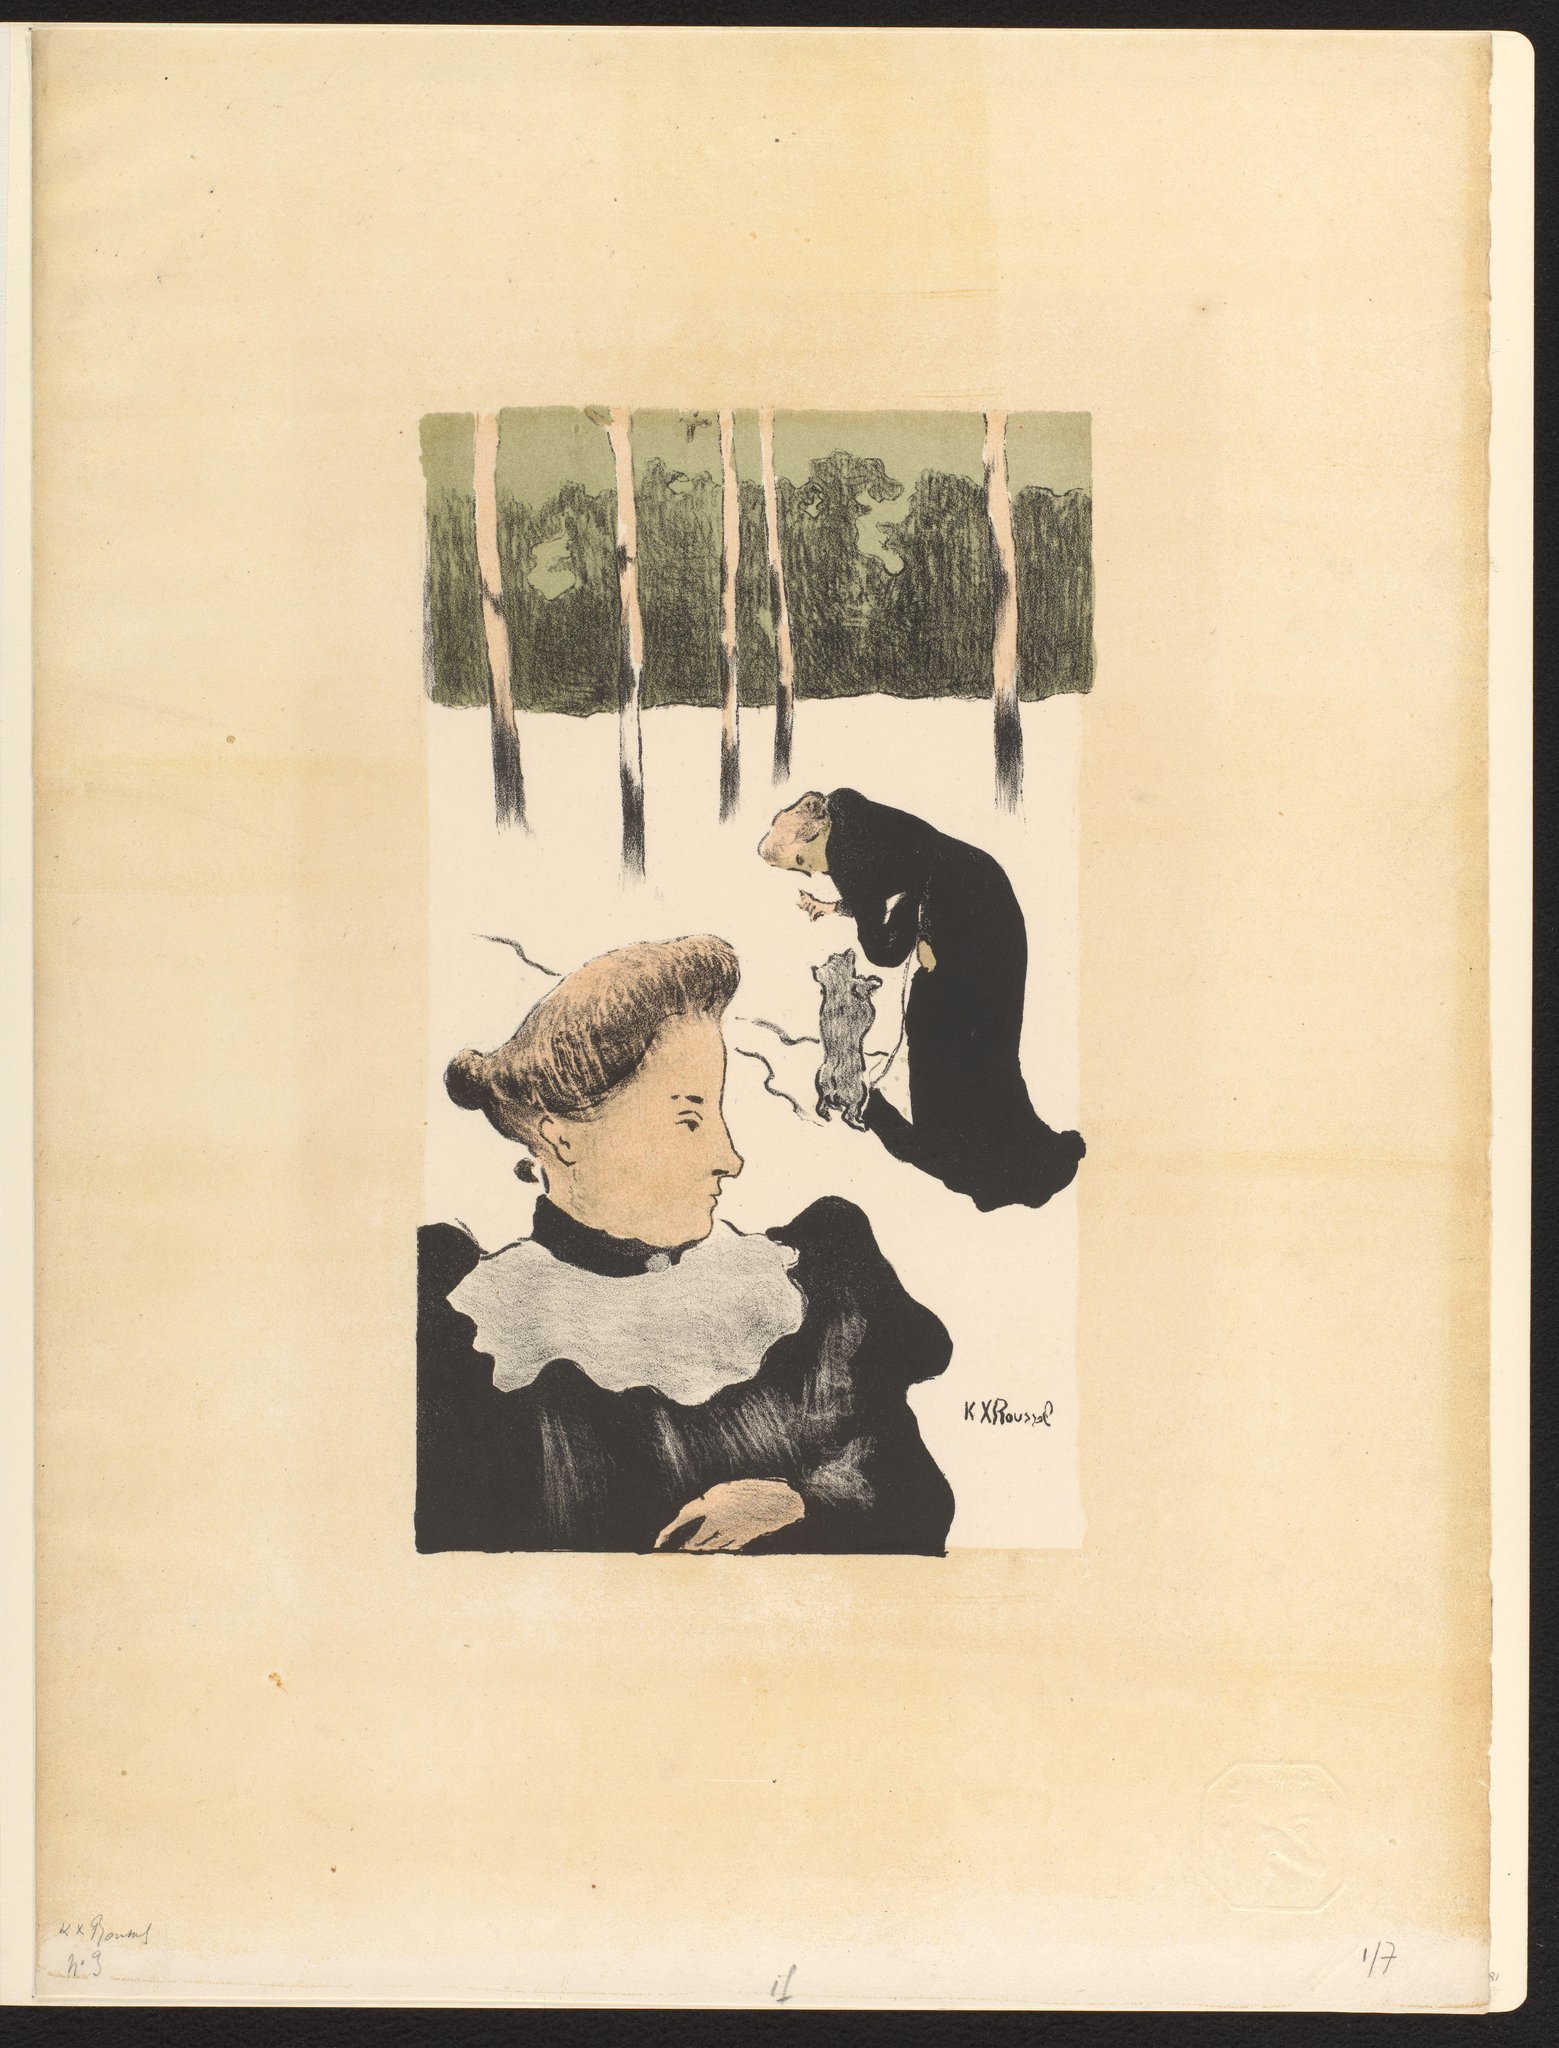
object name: print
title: Twee vrouwen en een hond in een landschap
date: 1893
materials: paper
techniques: lithograph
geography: paris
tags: adult woman (+ one person), training of dogs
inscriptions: check stamp: Lugt 819, collector's mark: Lugt 2228, inscription: ‘K X Roussel / no 9’, collector's mark: Lugt 2760